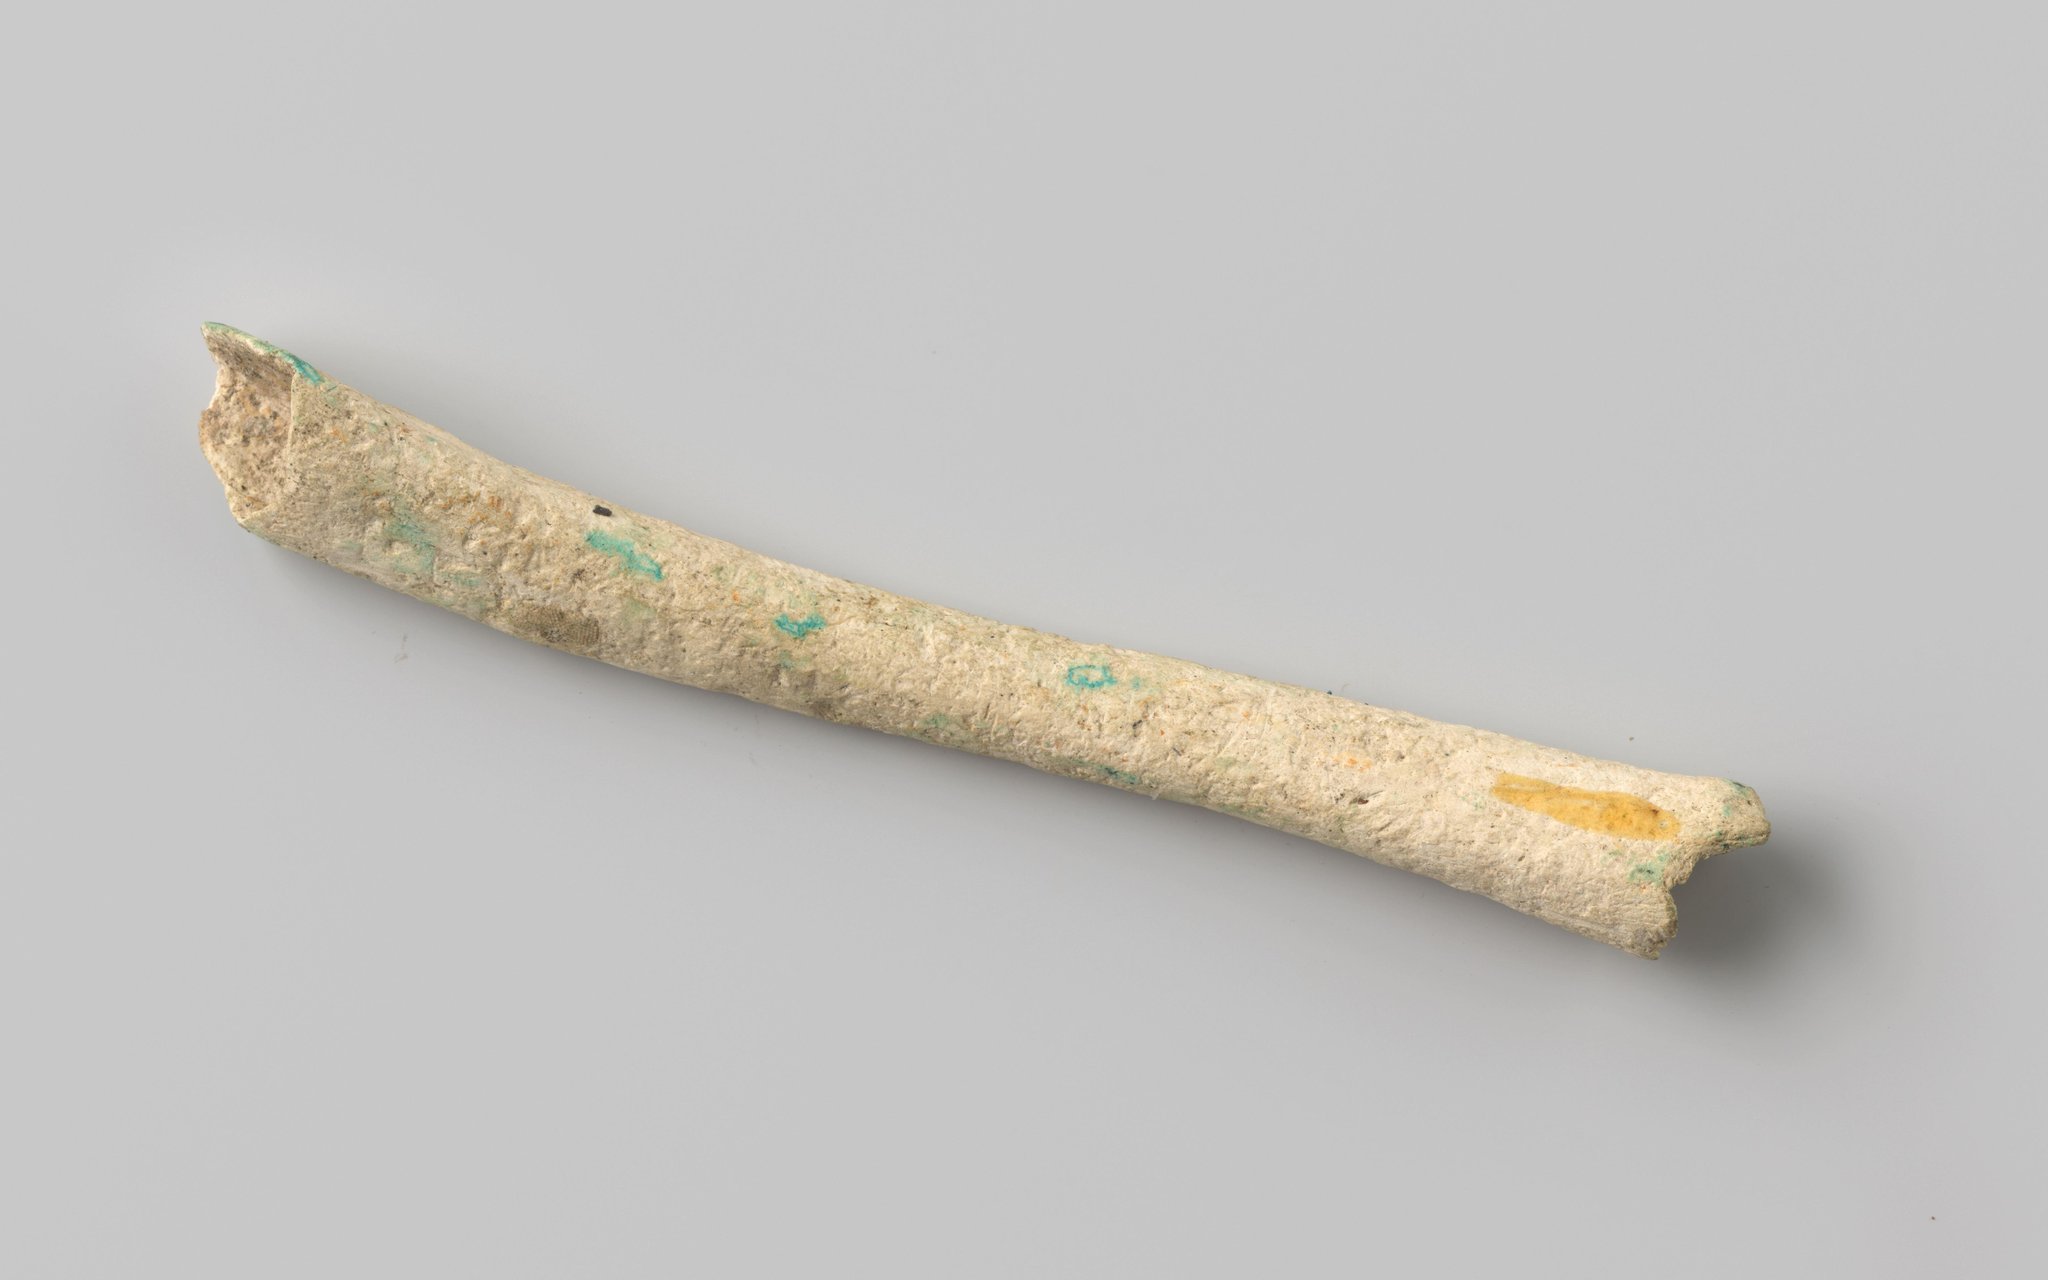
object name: bone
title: Scheenbeen van schaap of geit uit het wrak van de Oost-Indiëvaarder Hollandia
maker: niet van toepassing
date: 1700-1743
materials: bone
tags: verenigde oostindische compagnie, hollandia (schip), annet